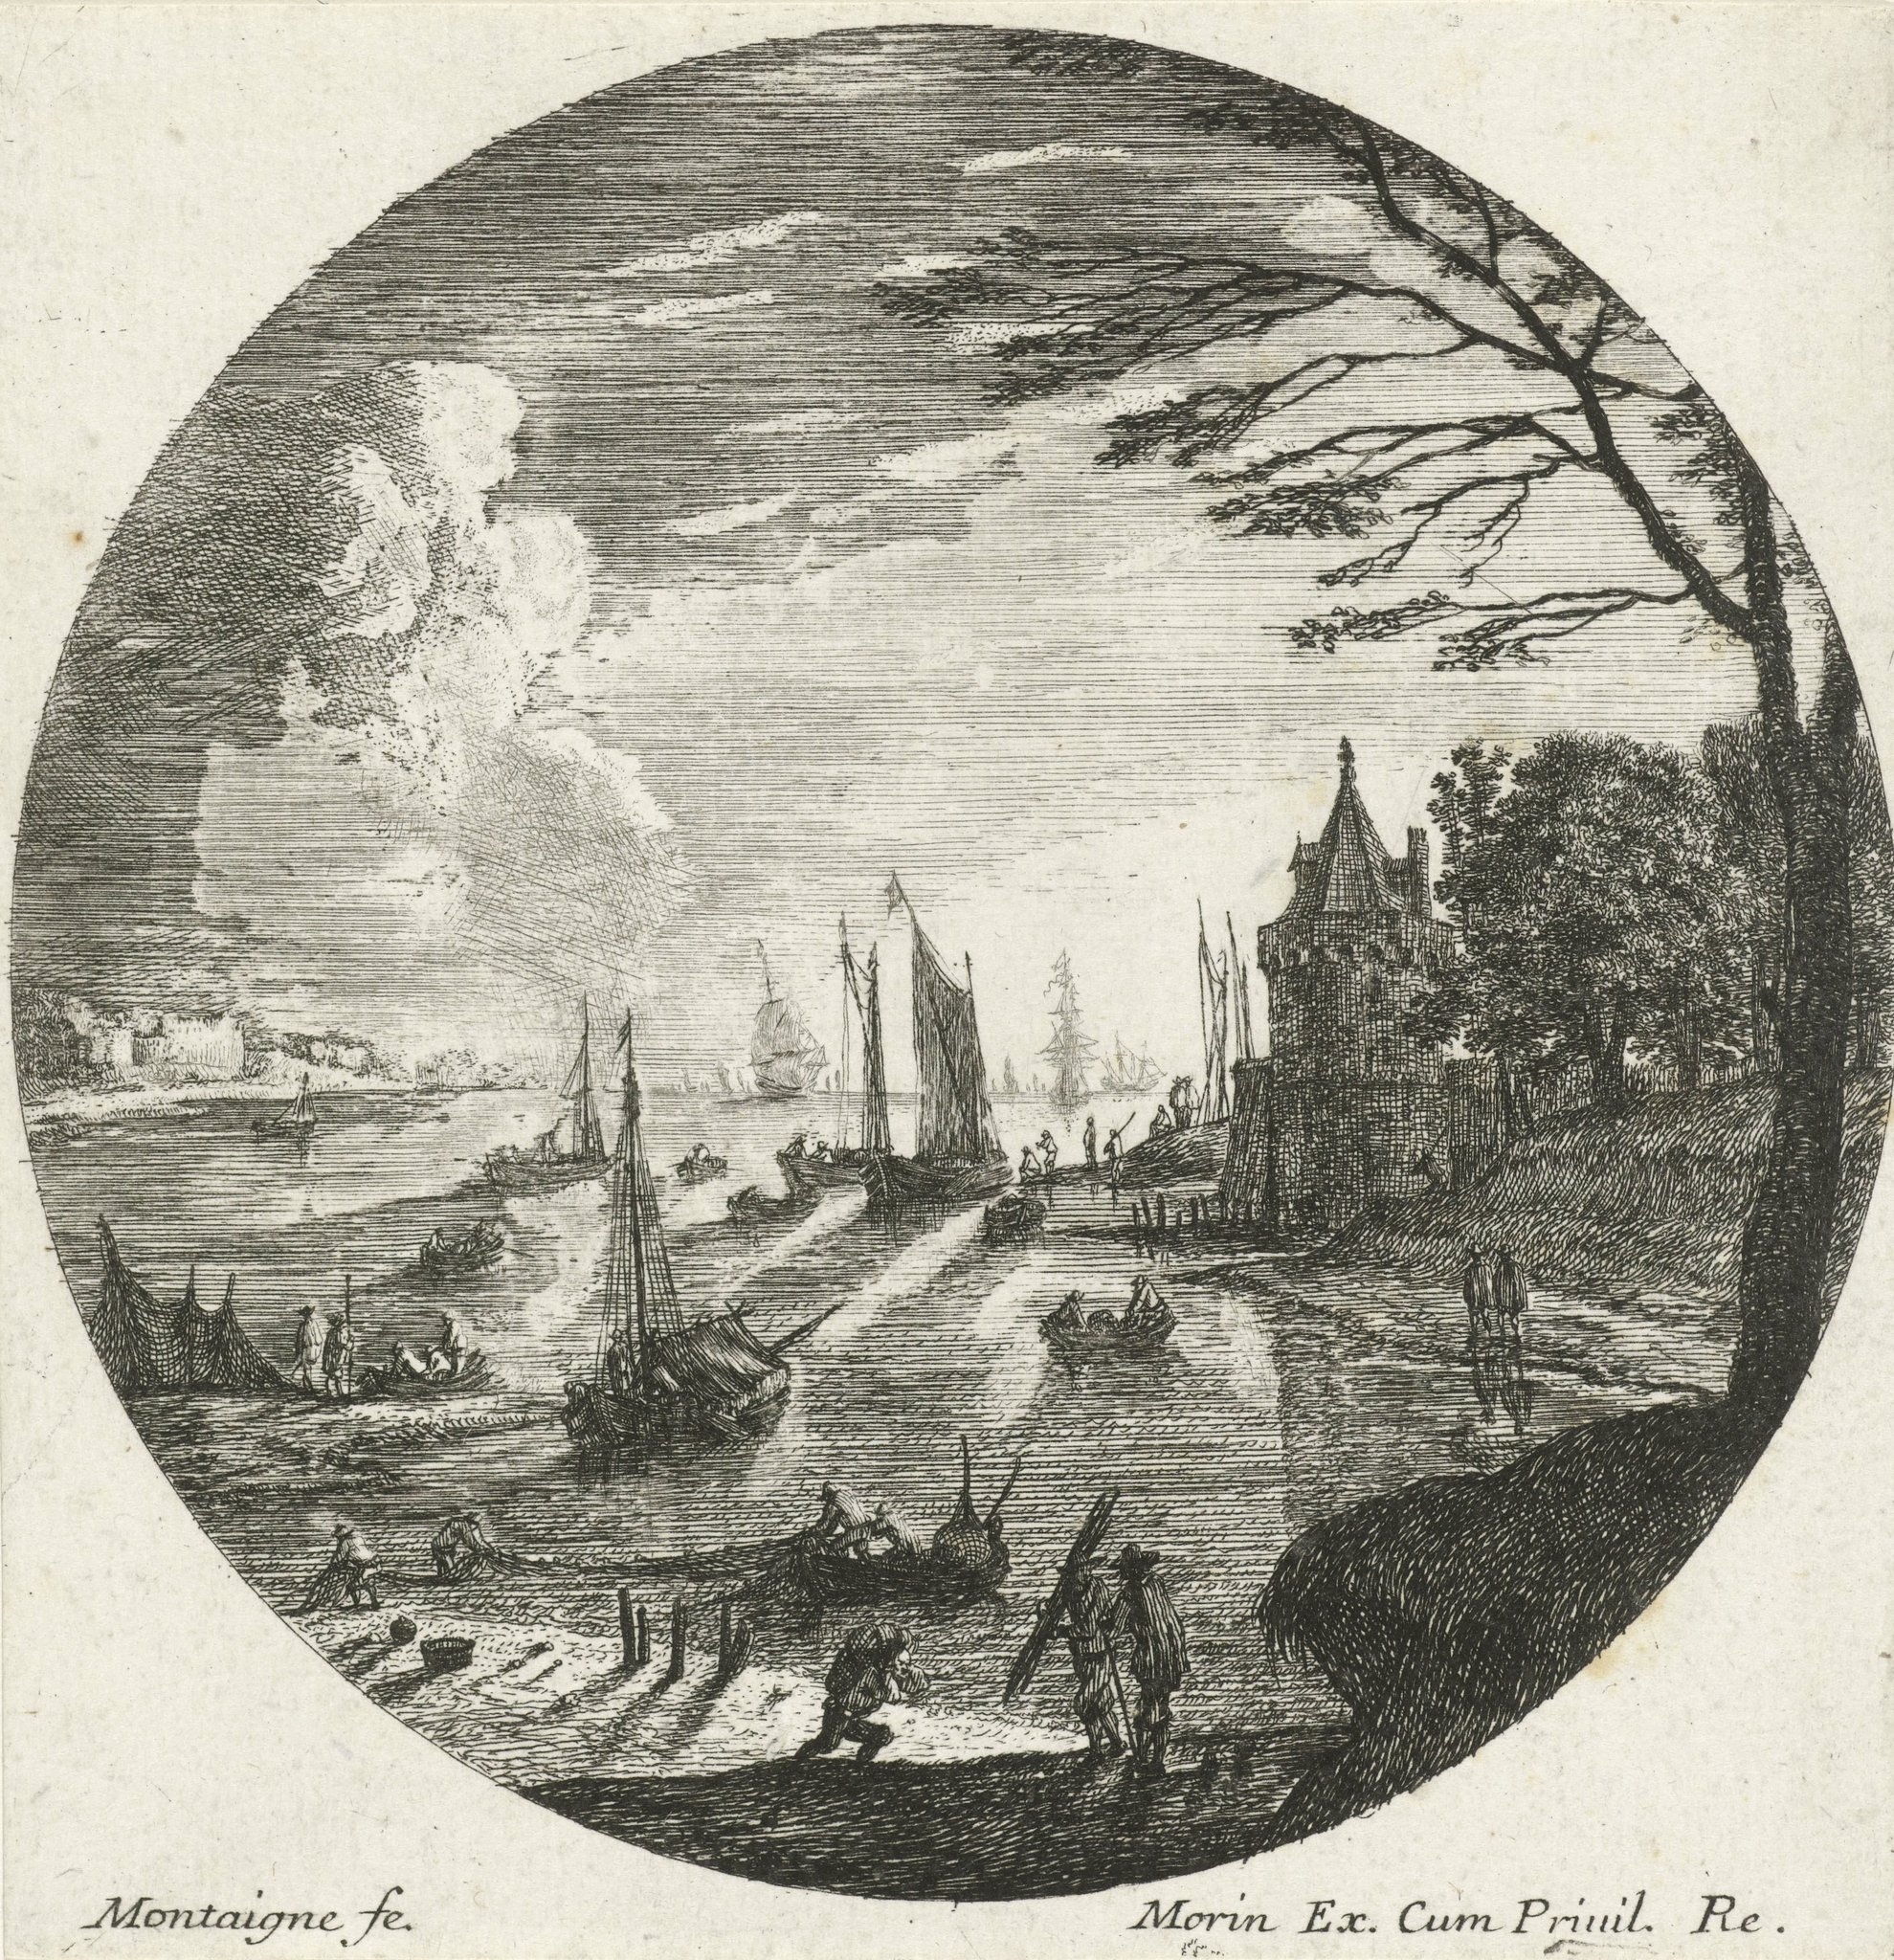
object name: print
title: Medaillons met landschappen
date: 1617-1660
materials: paper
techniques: etching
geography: paris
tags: landscape with tower or castle, sunset, fisherman, sea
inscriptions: collector's mark: Lugt 240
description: Landschap met een zonsondergang. Op de voorgrond vissers in de weer met hun netten. Op de achtergrond schepen op zee en een toren langs de kust.